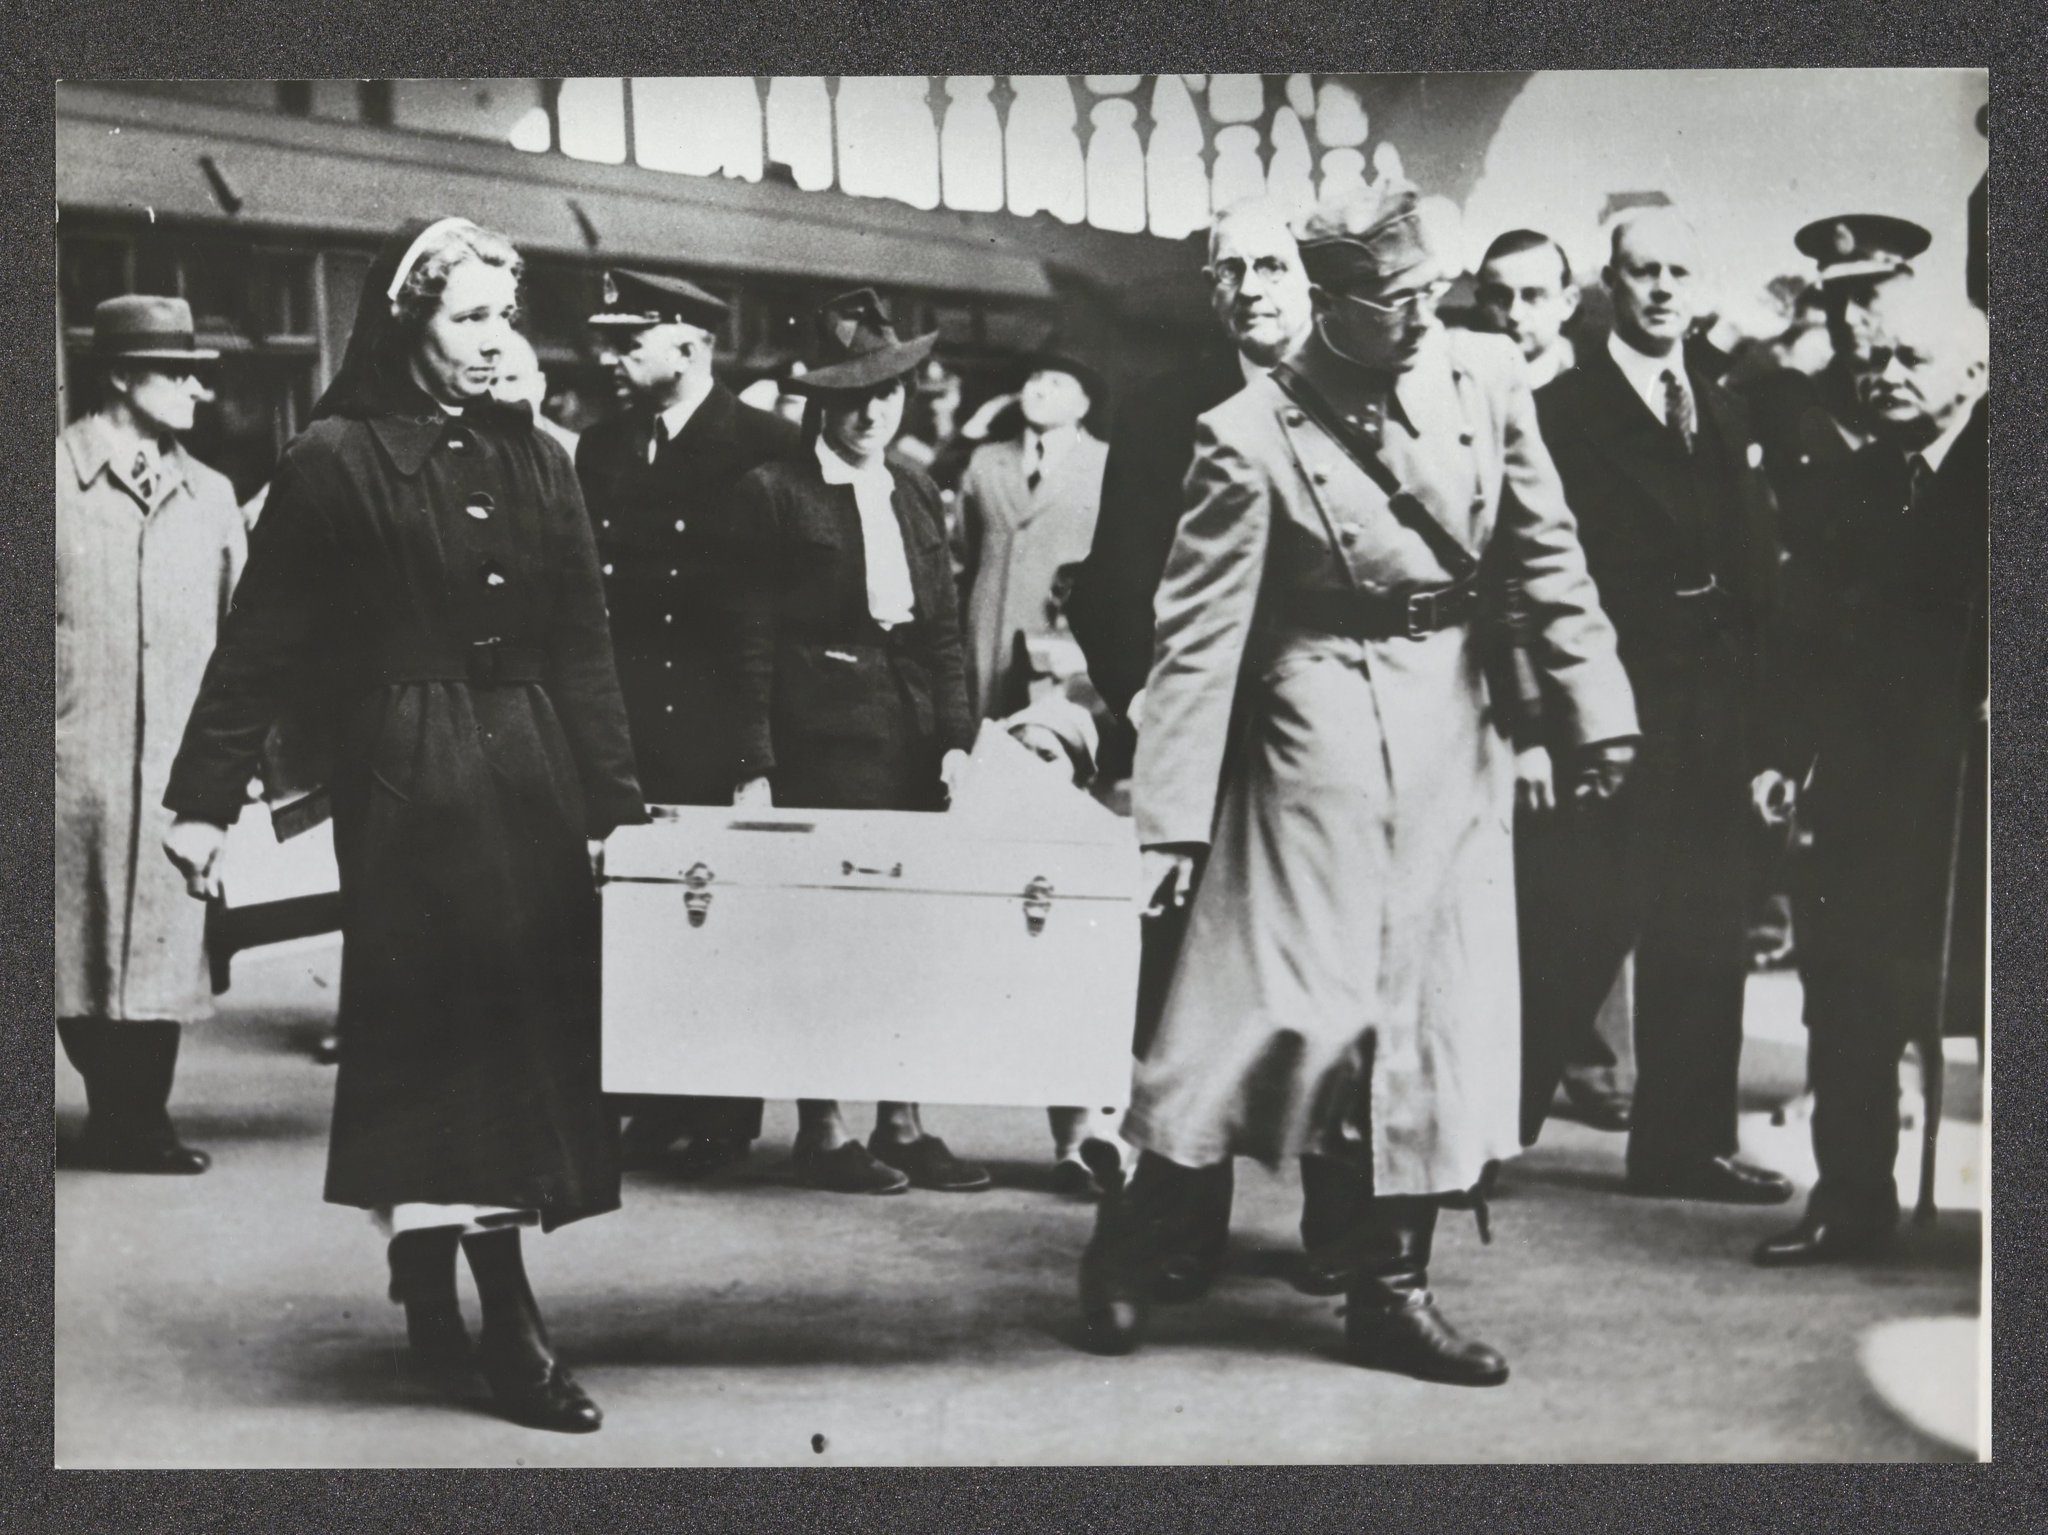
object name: photograph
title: Londen met reiswieg met Pr. Irene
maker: m.m. couvée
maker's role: publisher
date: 1940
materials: photographic support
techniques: gelatin silver print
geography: the hague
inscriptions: stamp: ‘Copyright ANEFO Kerkstraat 310 Amsterdam-C PRF17’